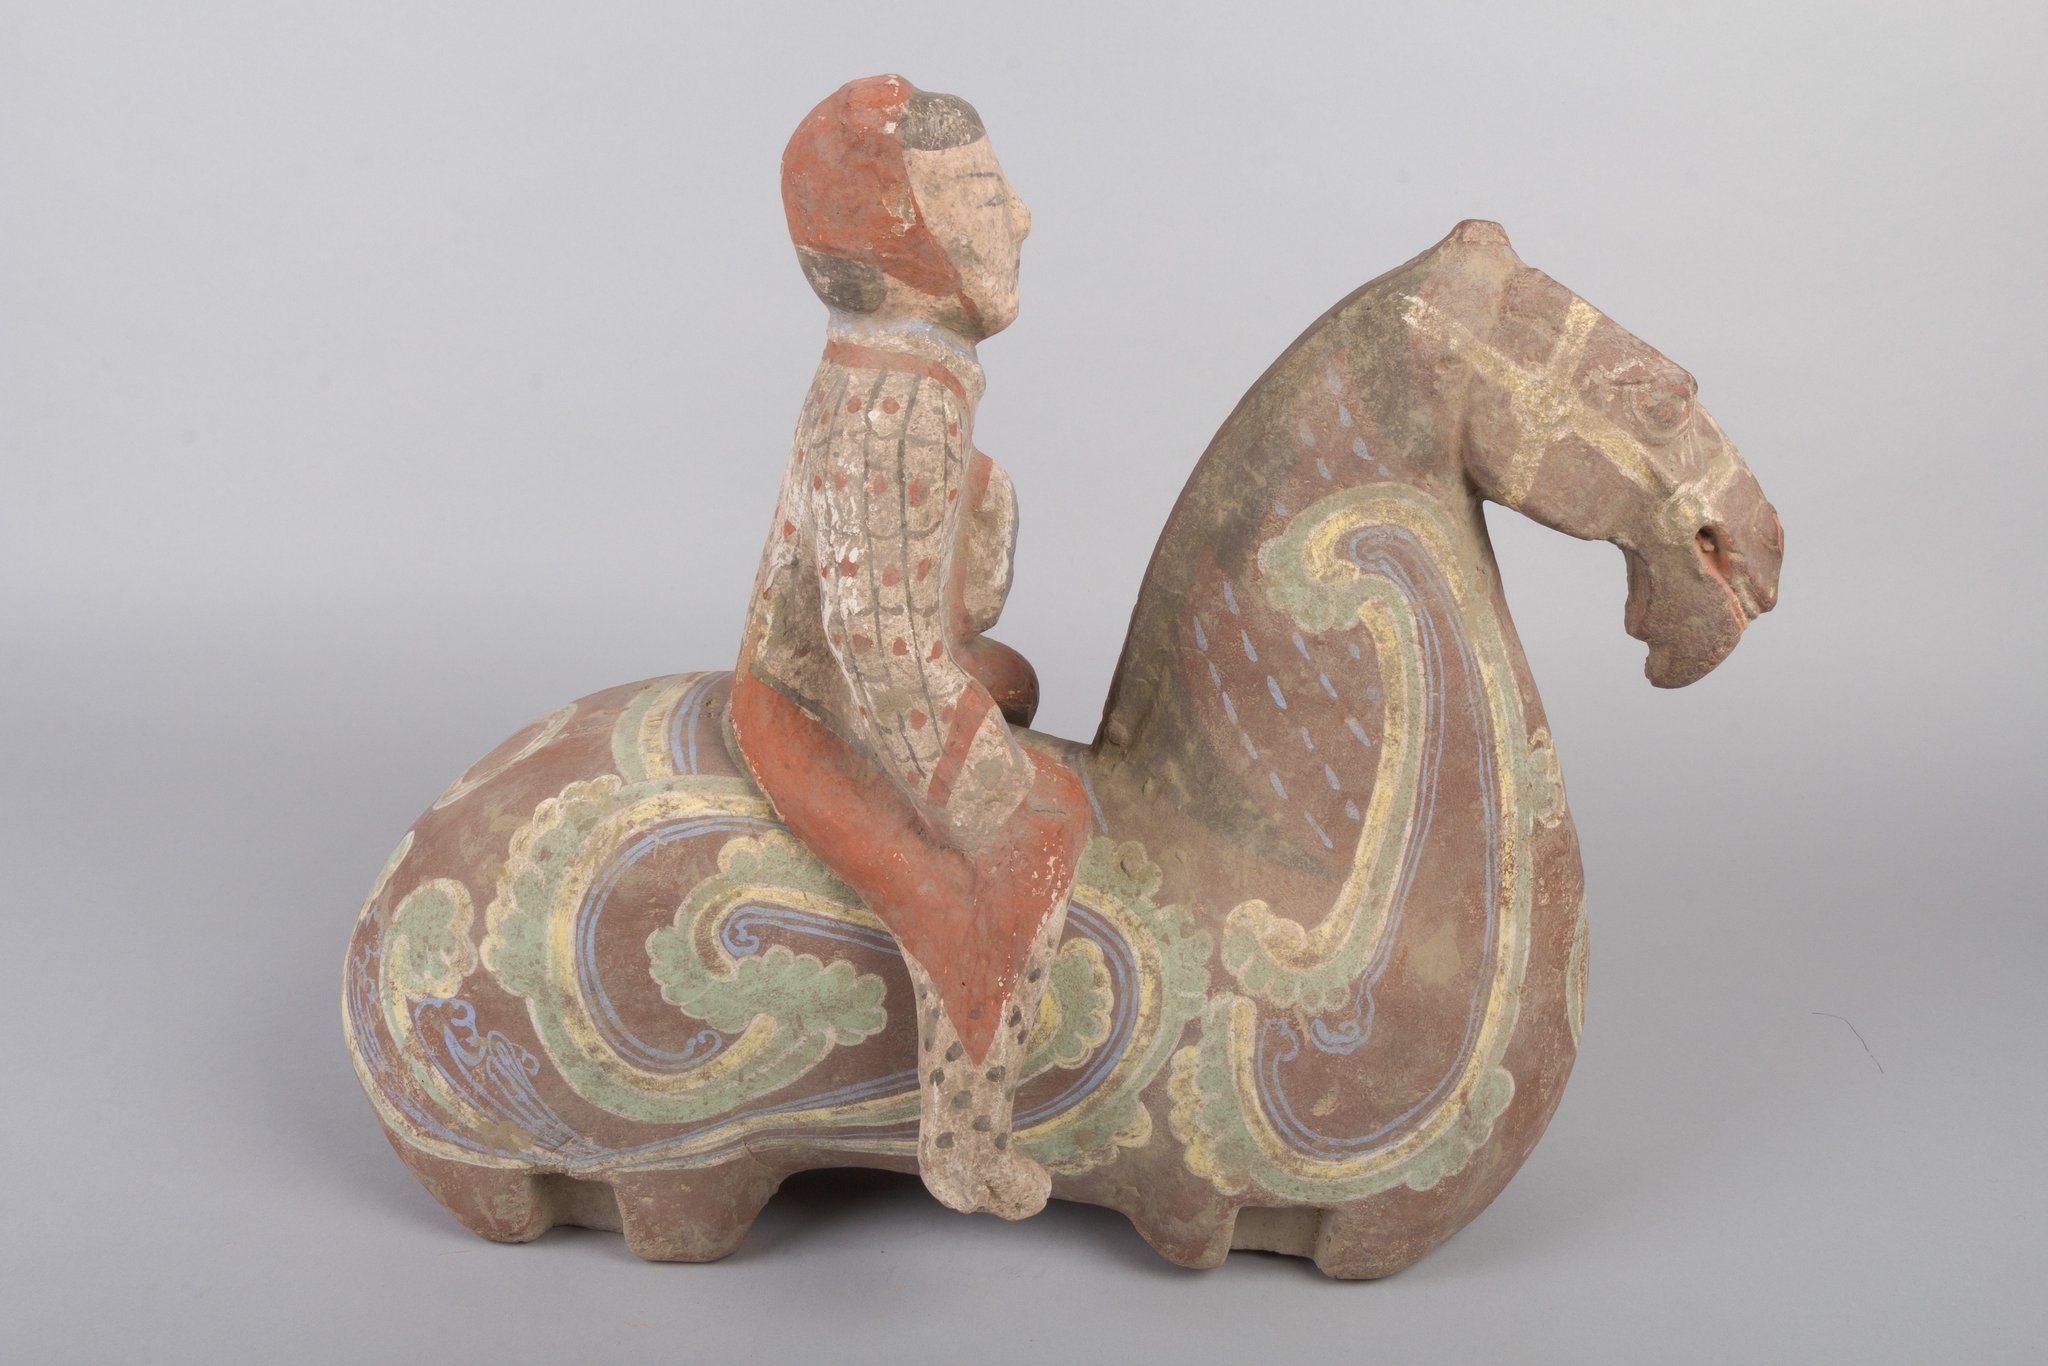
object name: figure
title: Kneeling Horse and Separately Modeled Rider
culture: chinese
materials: earthenware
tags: men,horses